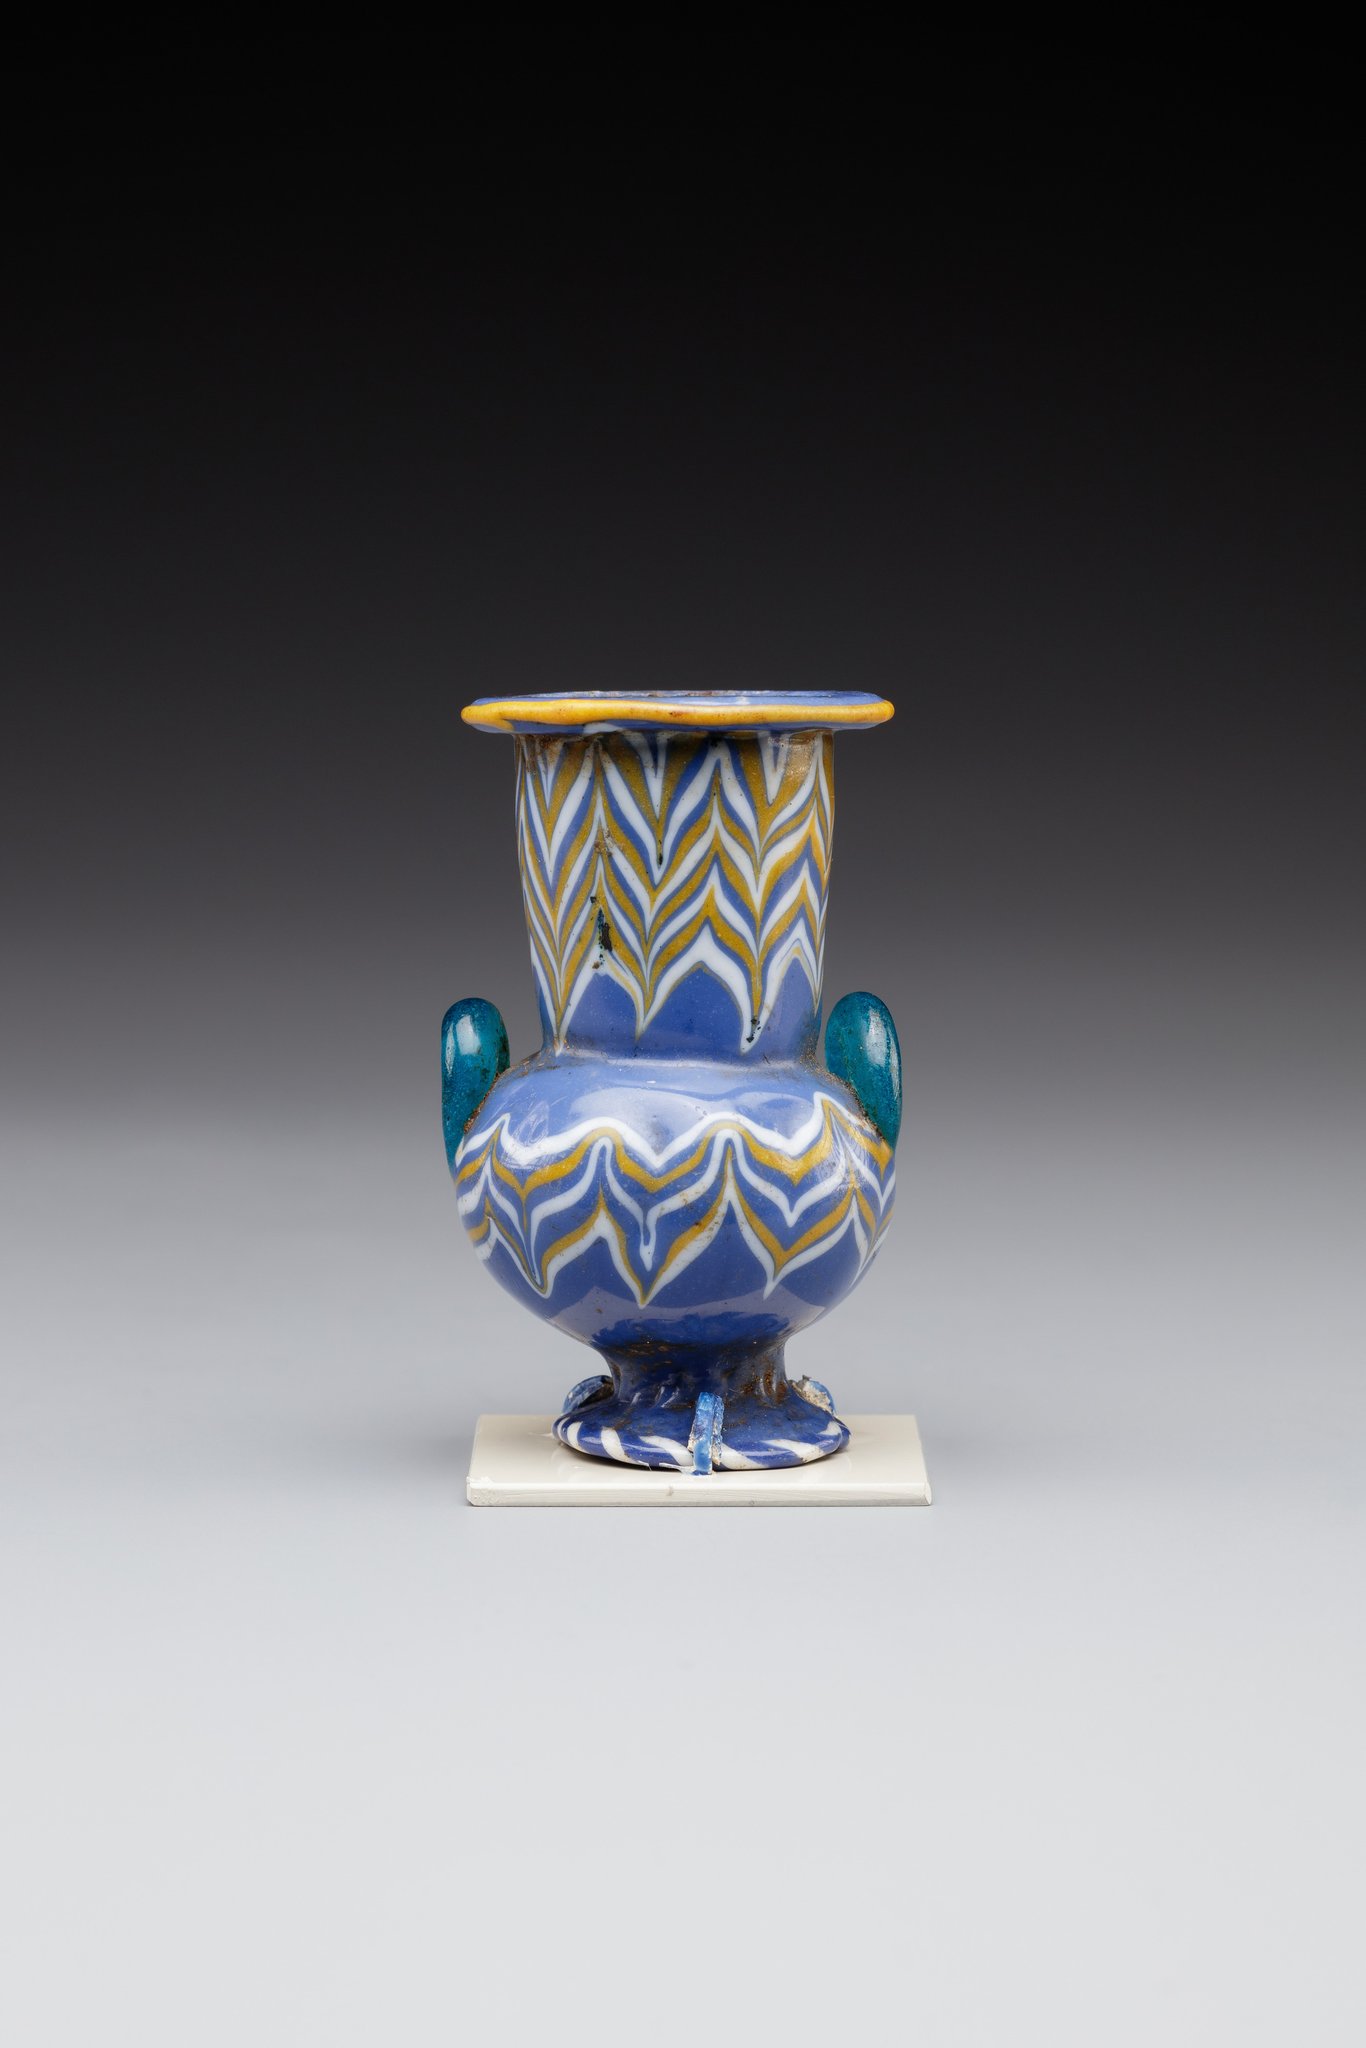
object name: jar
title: Glass Jar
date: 1353-1323 BCE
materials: glass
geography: egypt